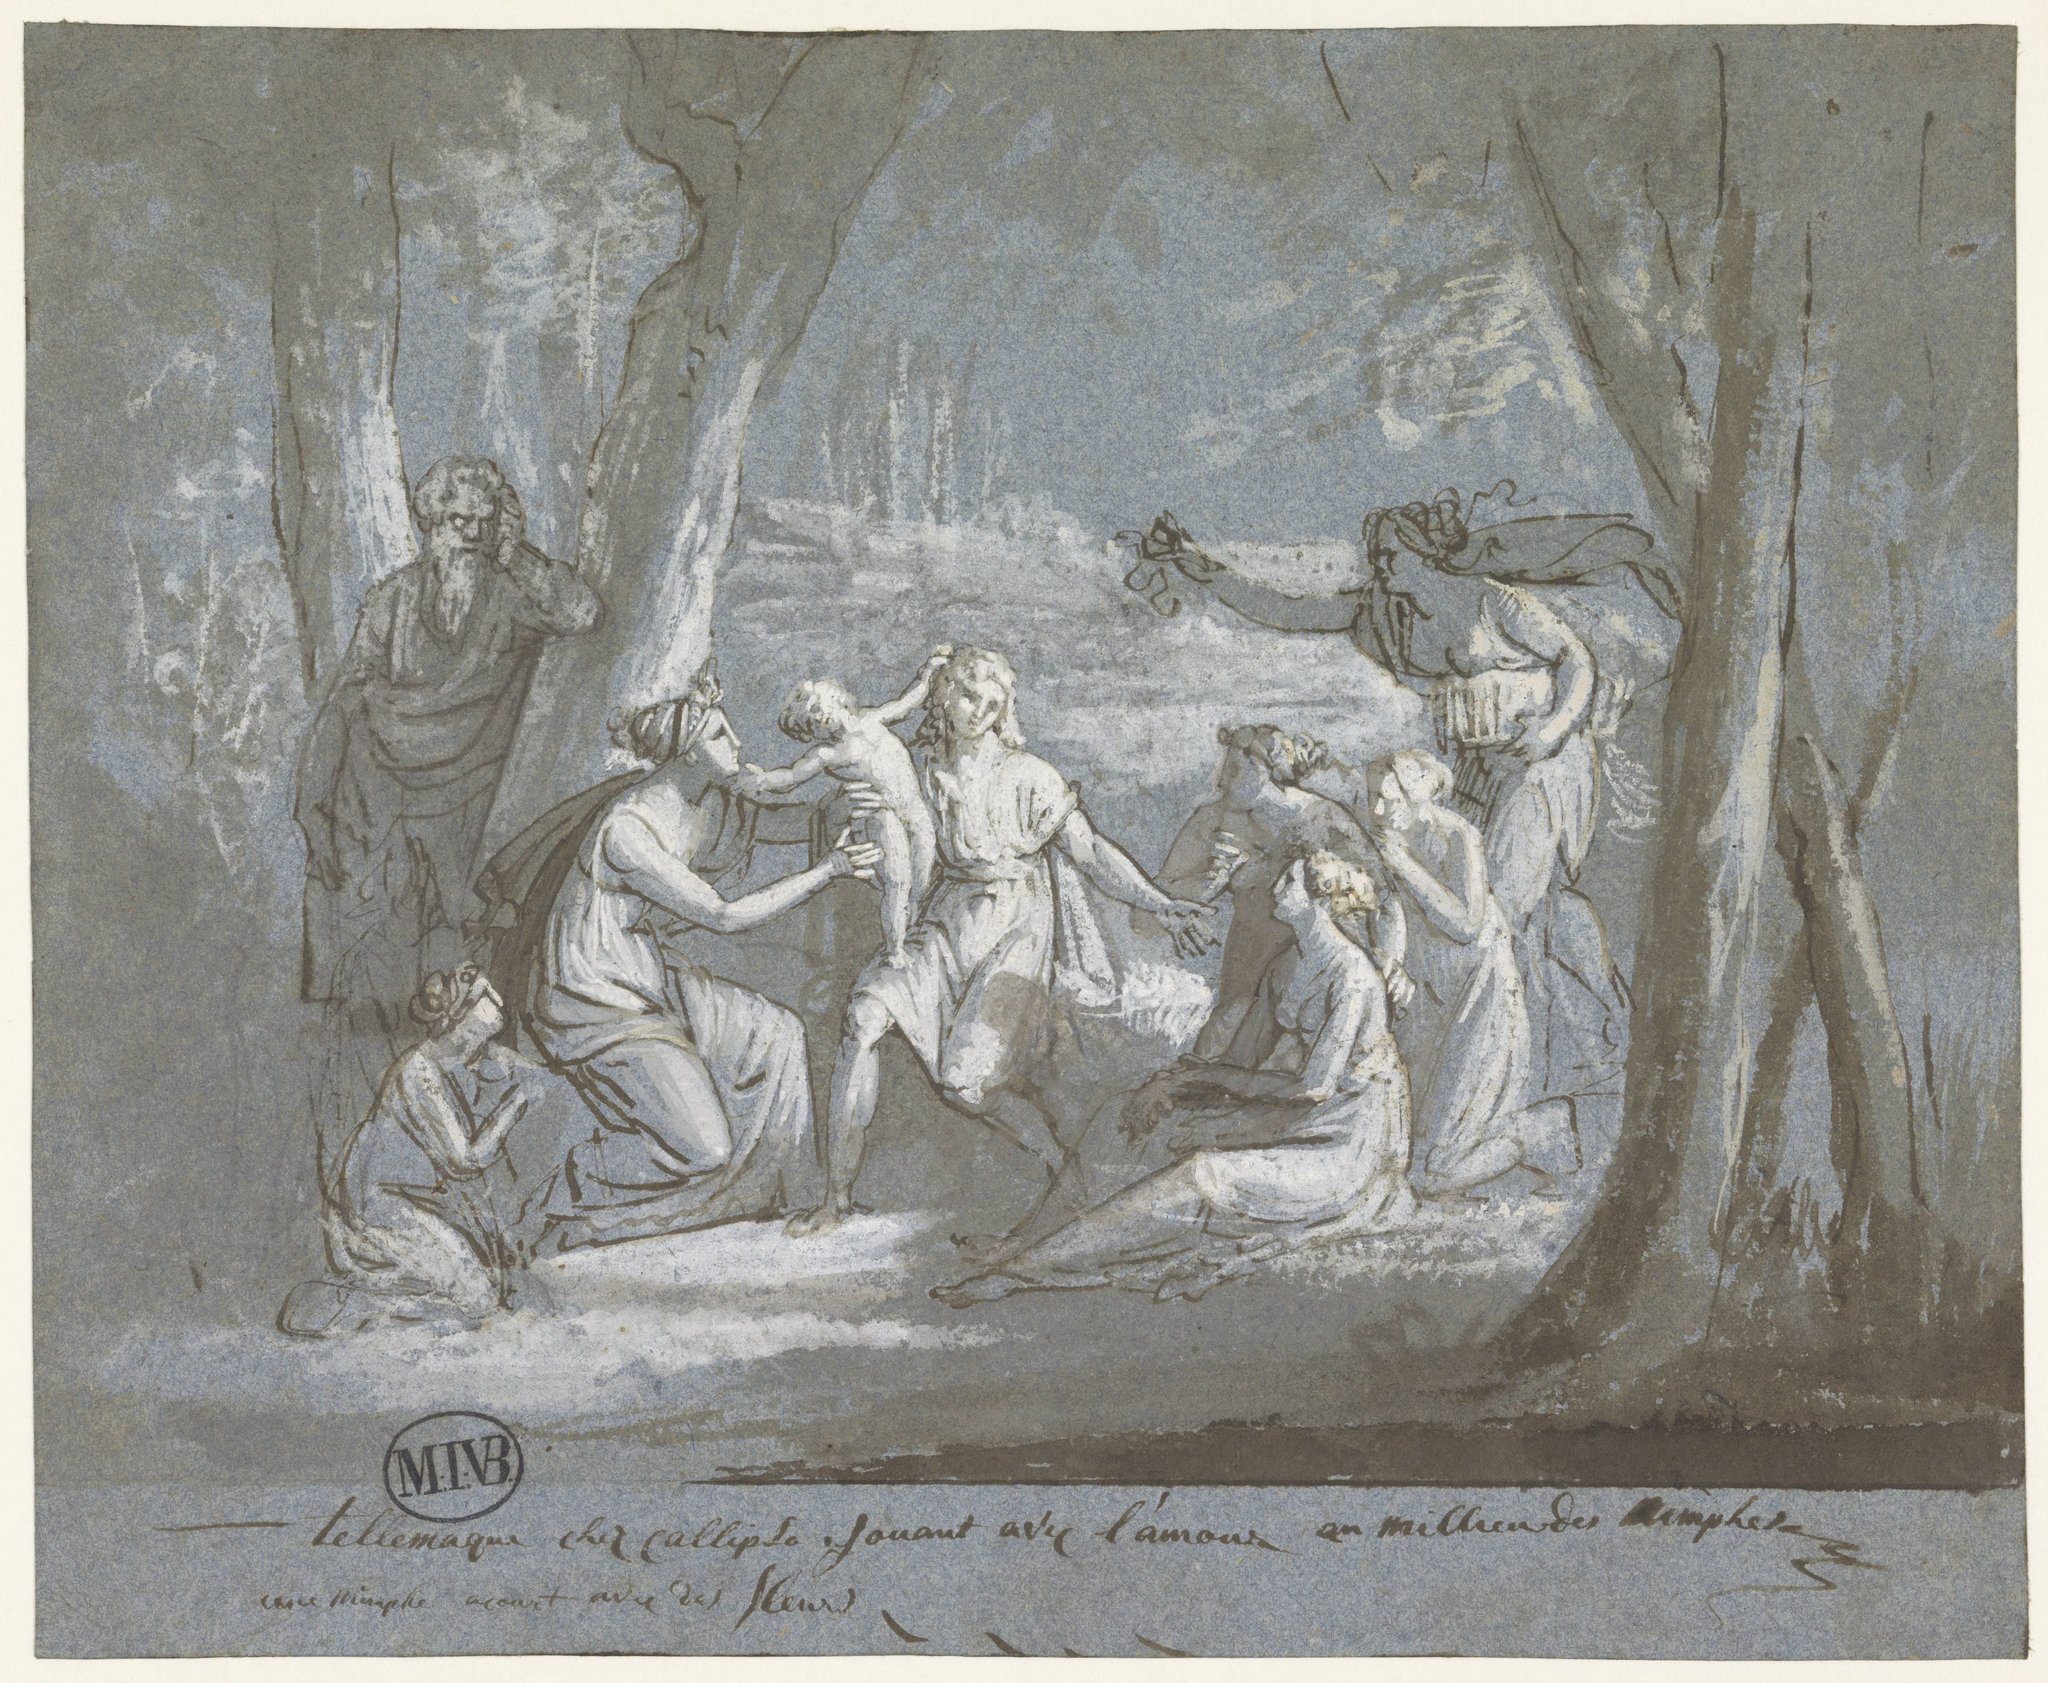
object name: drawing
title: Telemachus en Calypso spelend met een Amor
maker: mattheus ignatius van bree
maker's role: draughtsman, print maker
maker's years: 1773-1839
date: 1783-1839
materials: paint, ink, paper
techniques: brush, pen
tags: telemachus and calypso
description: Telemachus en Calypso temidden van hun gezelschap spelend met een Amor.